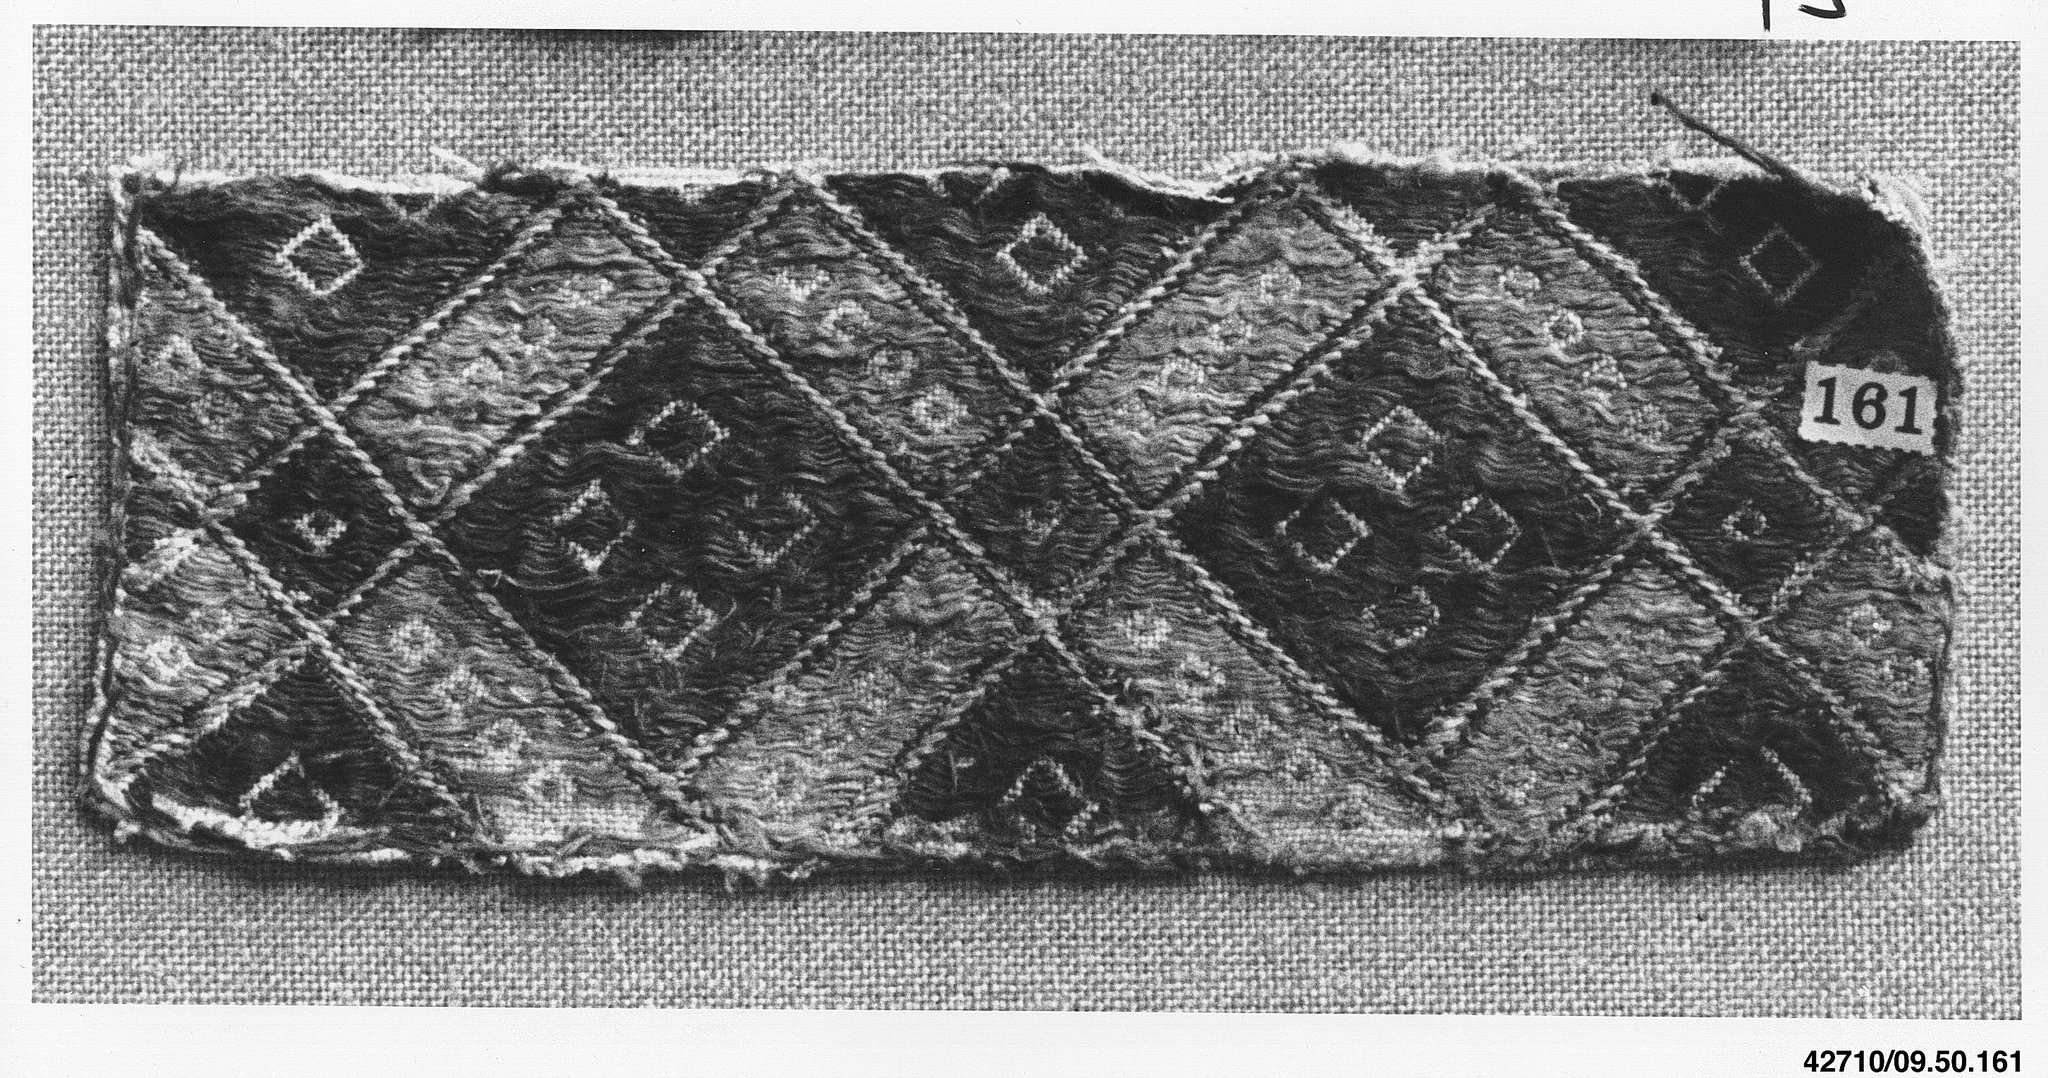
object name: costume fragment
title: Peasant costume fragment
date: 1801-1900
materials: canvas, silk